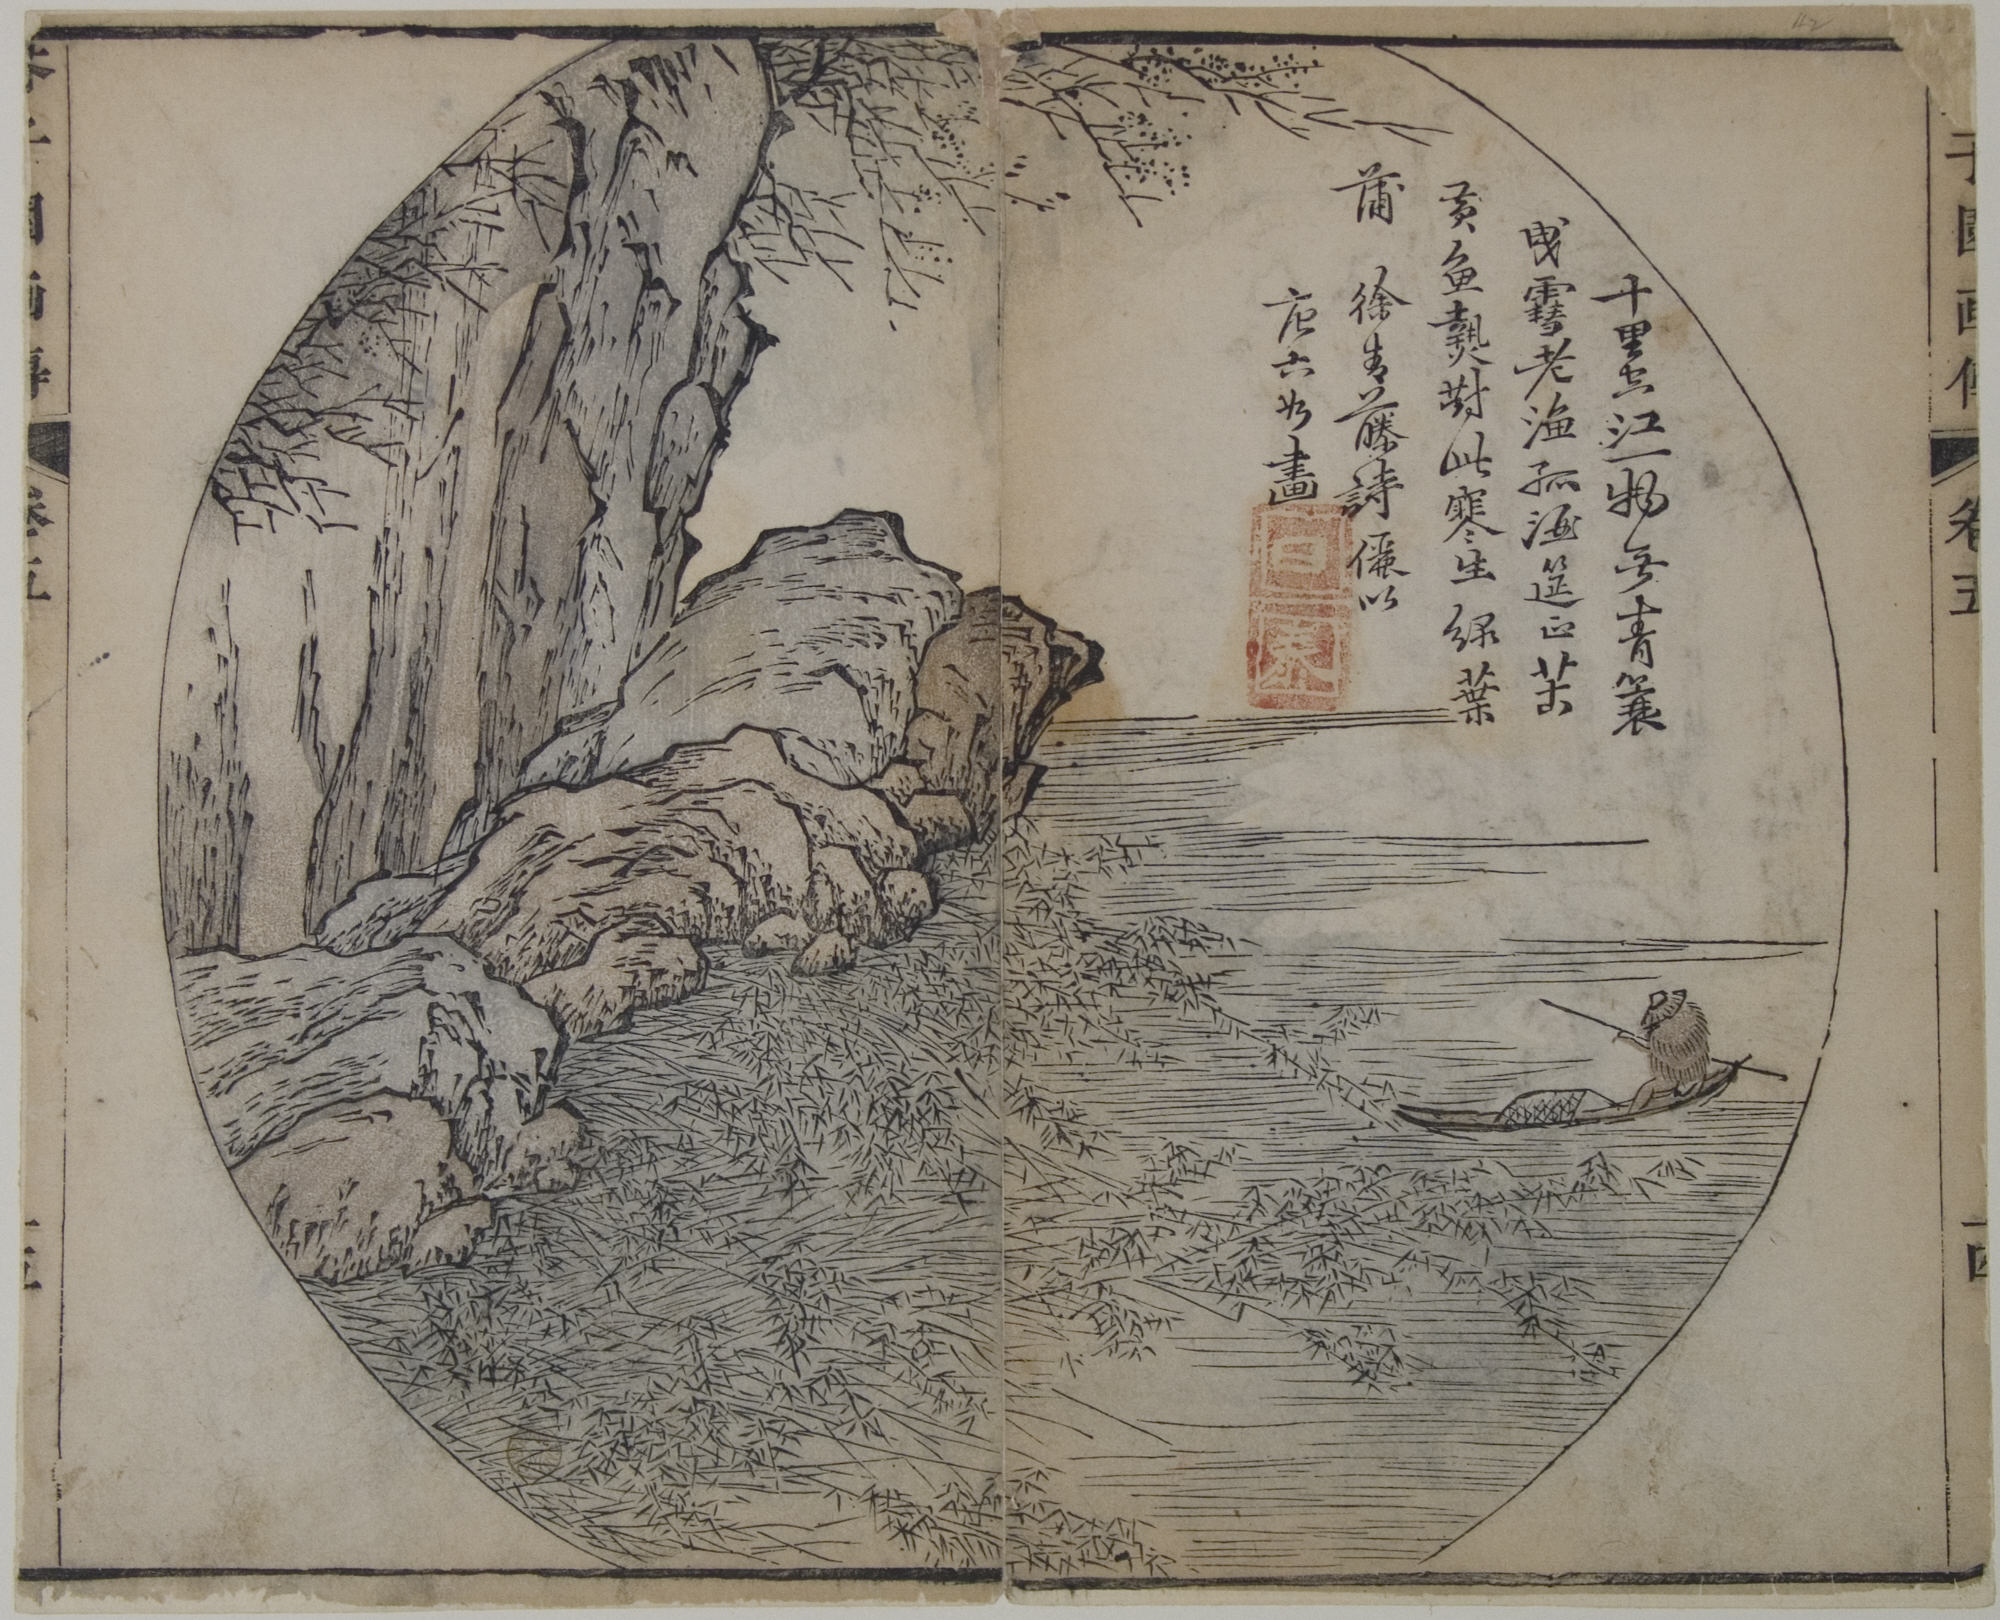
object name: print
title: Page from the Mustard Seed Garden Manual of Painting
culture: chinese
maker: wang gai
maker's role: artist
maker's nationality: chinese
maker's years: 1645-1710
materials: ink, paper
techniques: woodblock print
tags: hills,boats